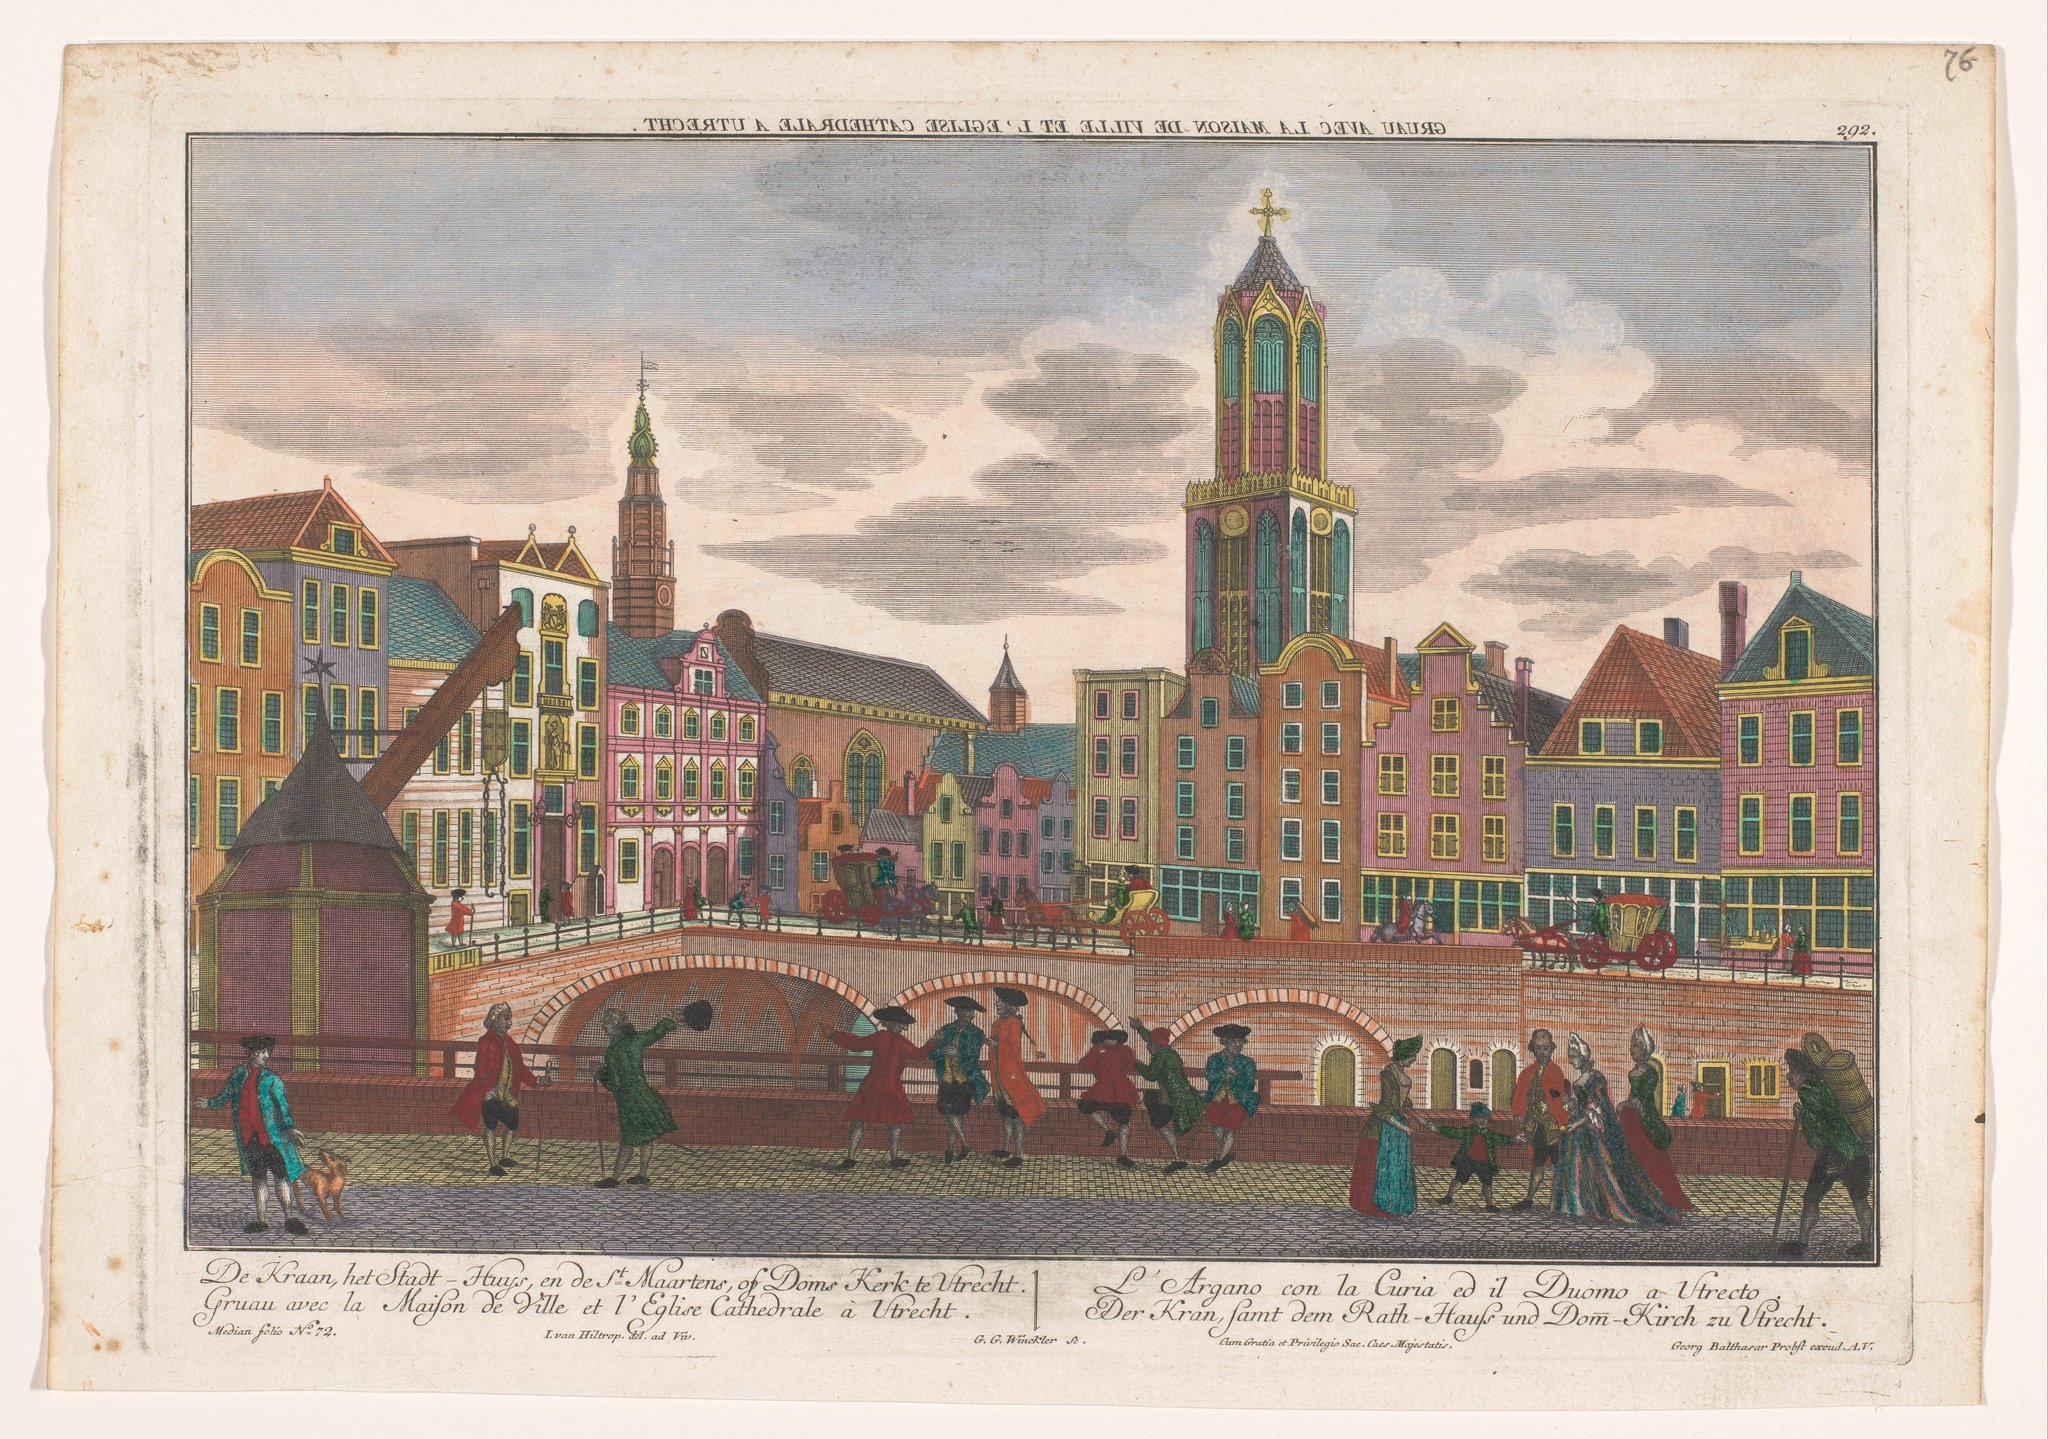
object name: print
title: Utrecht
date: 1742-1801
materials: paper, watercolor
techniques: brush, etching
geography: augsburg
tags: bridge in city across river, canal, etc. (+ city(-scape) with figures, staffage), church (exterior), townhall, street (+ city(-scape) with figures, staffage), parts of church exterior and annexes: tower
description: De serie “Utrecht”, met het nummer 72, bevat vier prenten met de nummers 291-294, waarvan dit nummer 292 is.